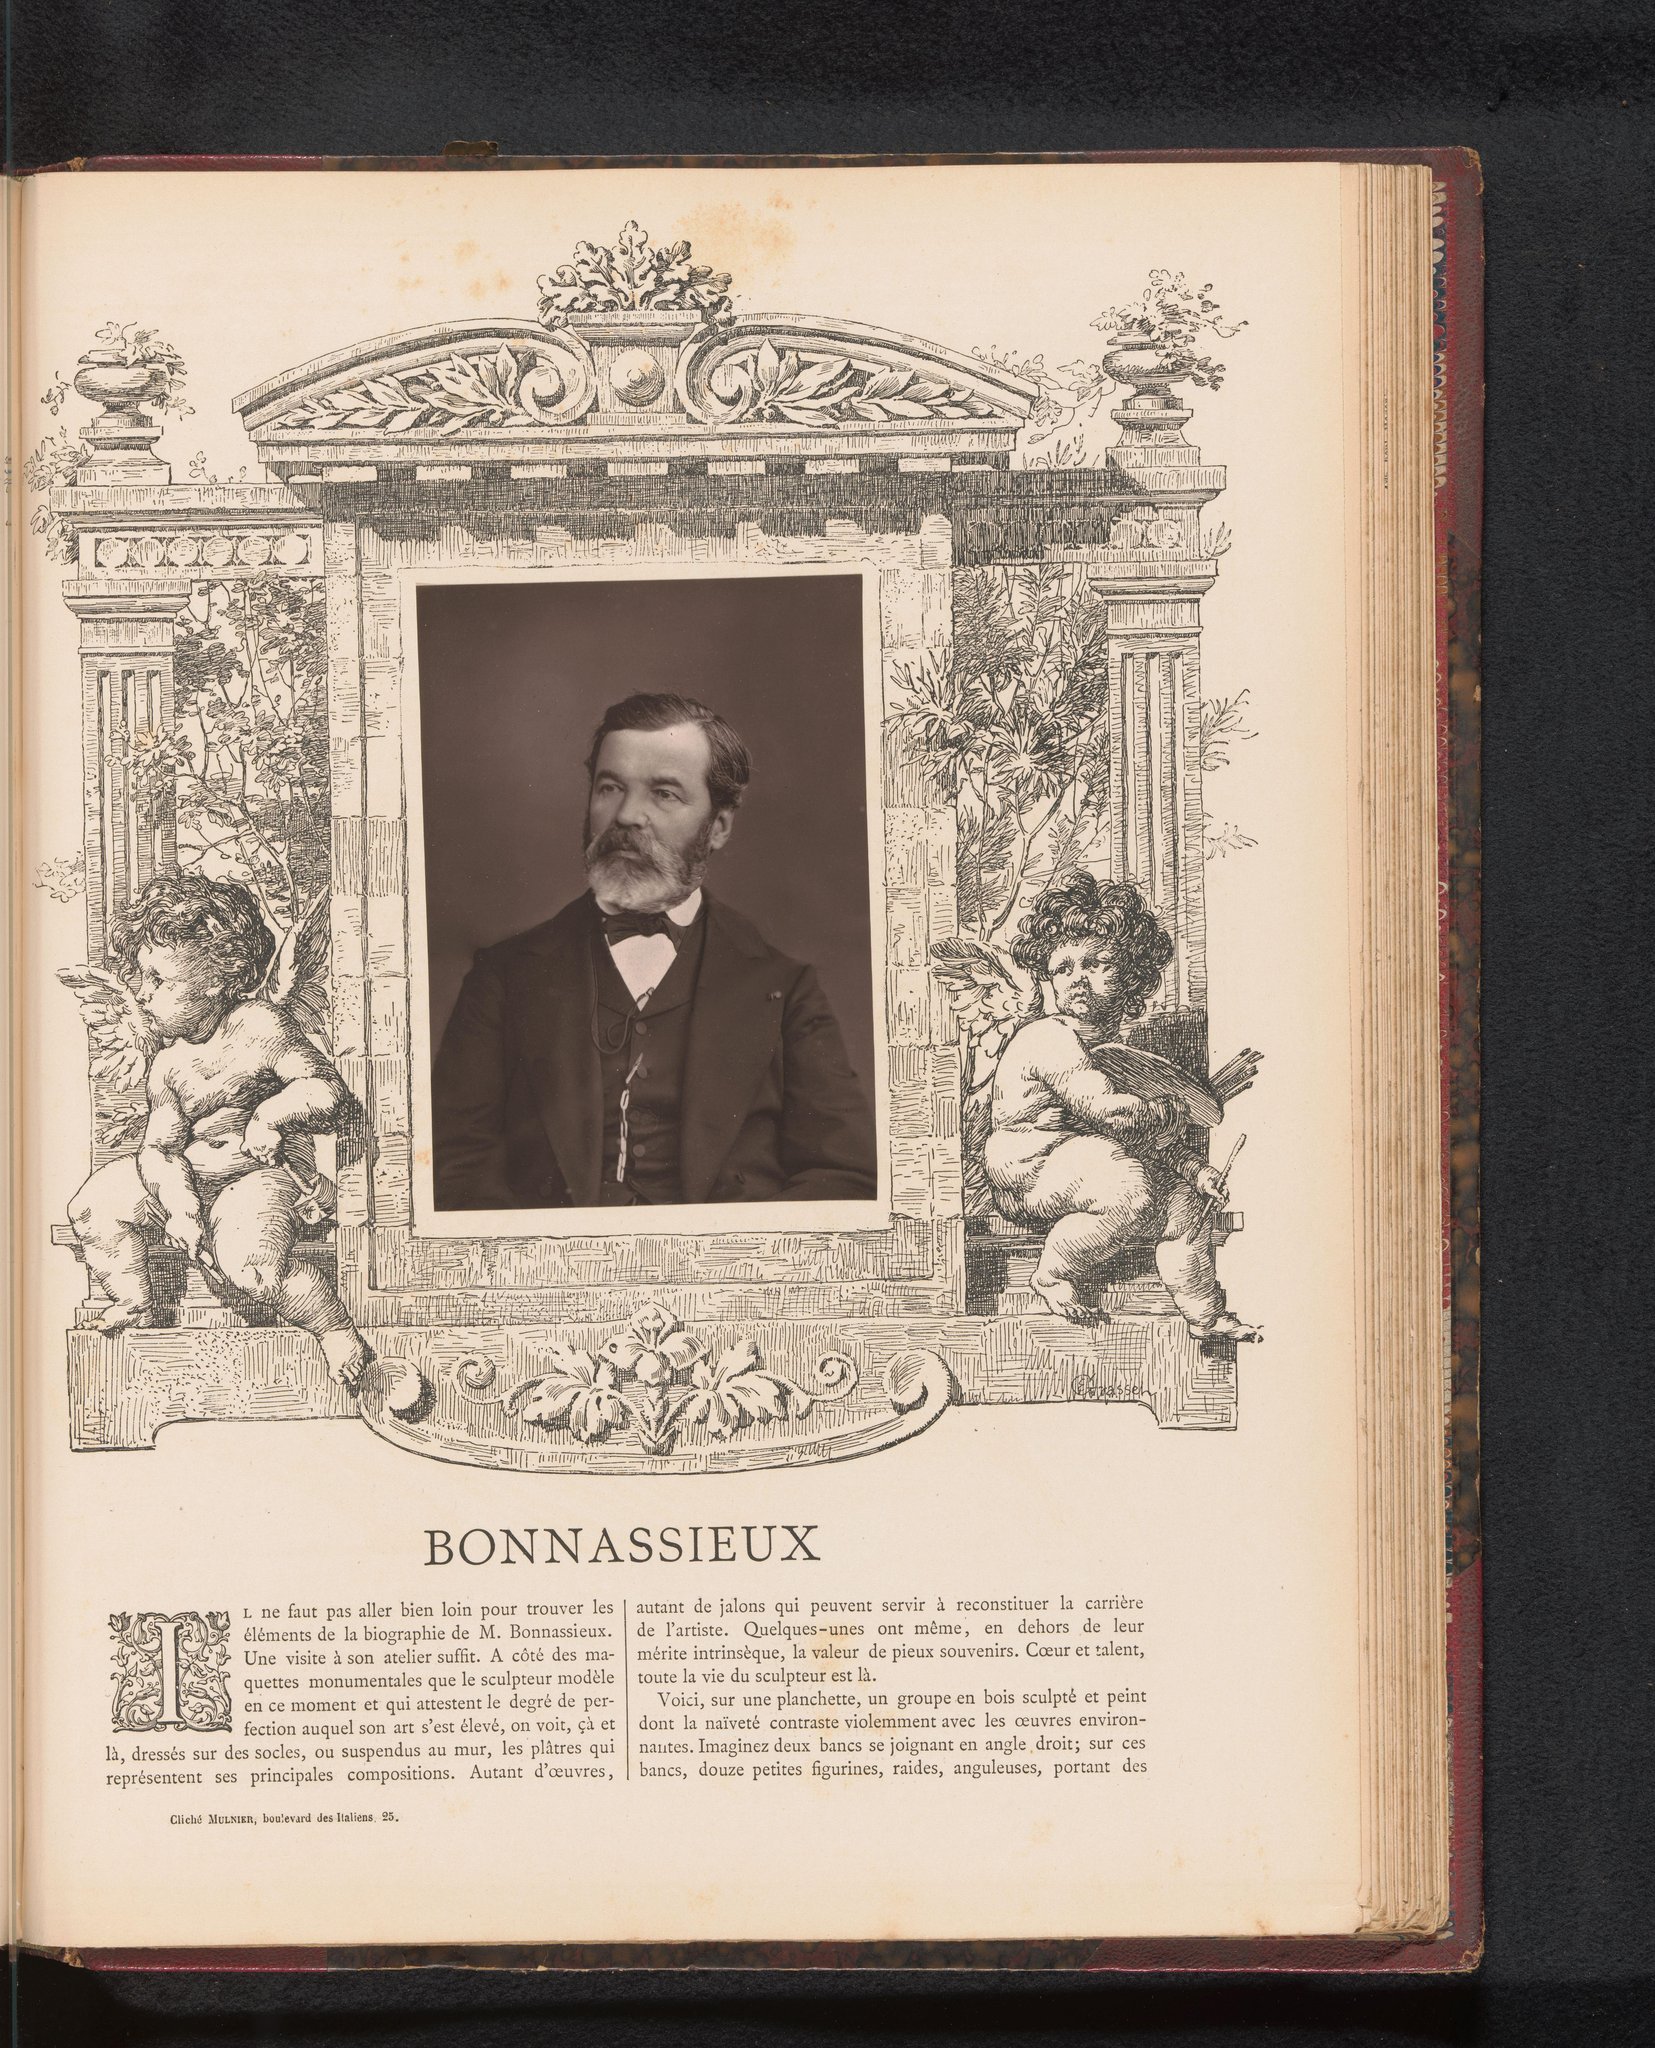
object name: page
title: Portret van Jean-Marie Bonnassieux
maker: ferdinand mulnier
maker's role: painter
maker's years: 1817-1891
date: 1873-1878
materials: paper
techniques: woodburytype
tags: paris, sculptor, jean-marie bonnassieux, adult man, historical persons